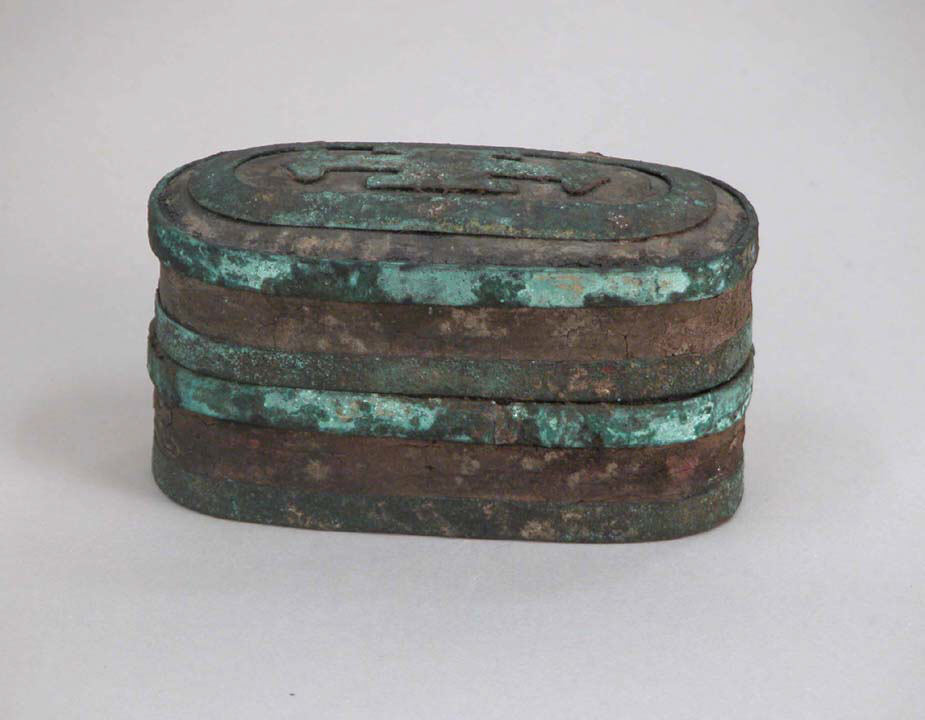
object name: box with cover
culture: chinese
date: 206 BCE-220 CE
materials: bronze, wood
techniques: lacquer